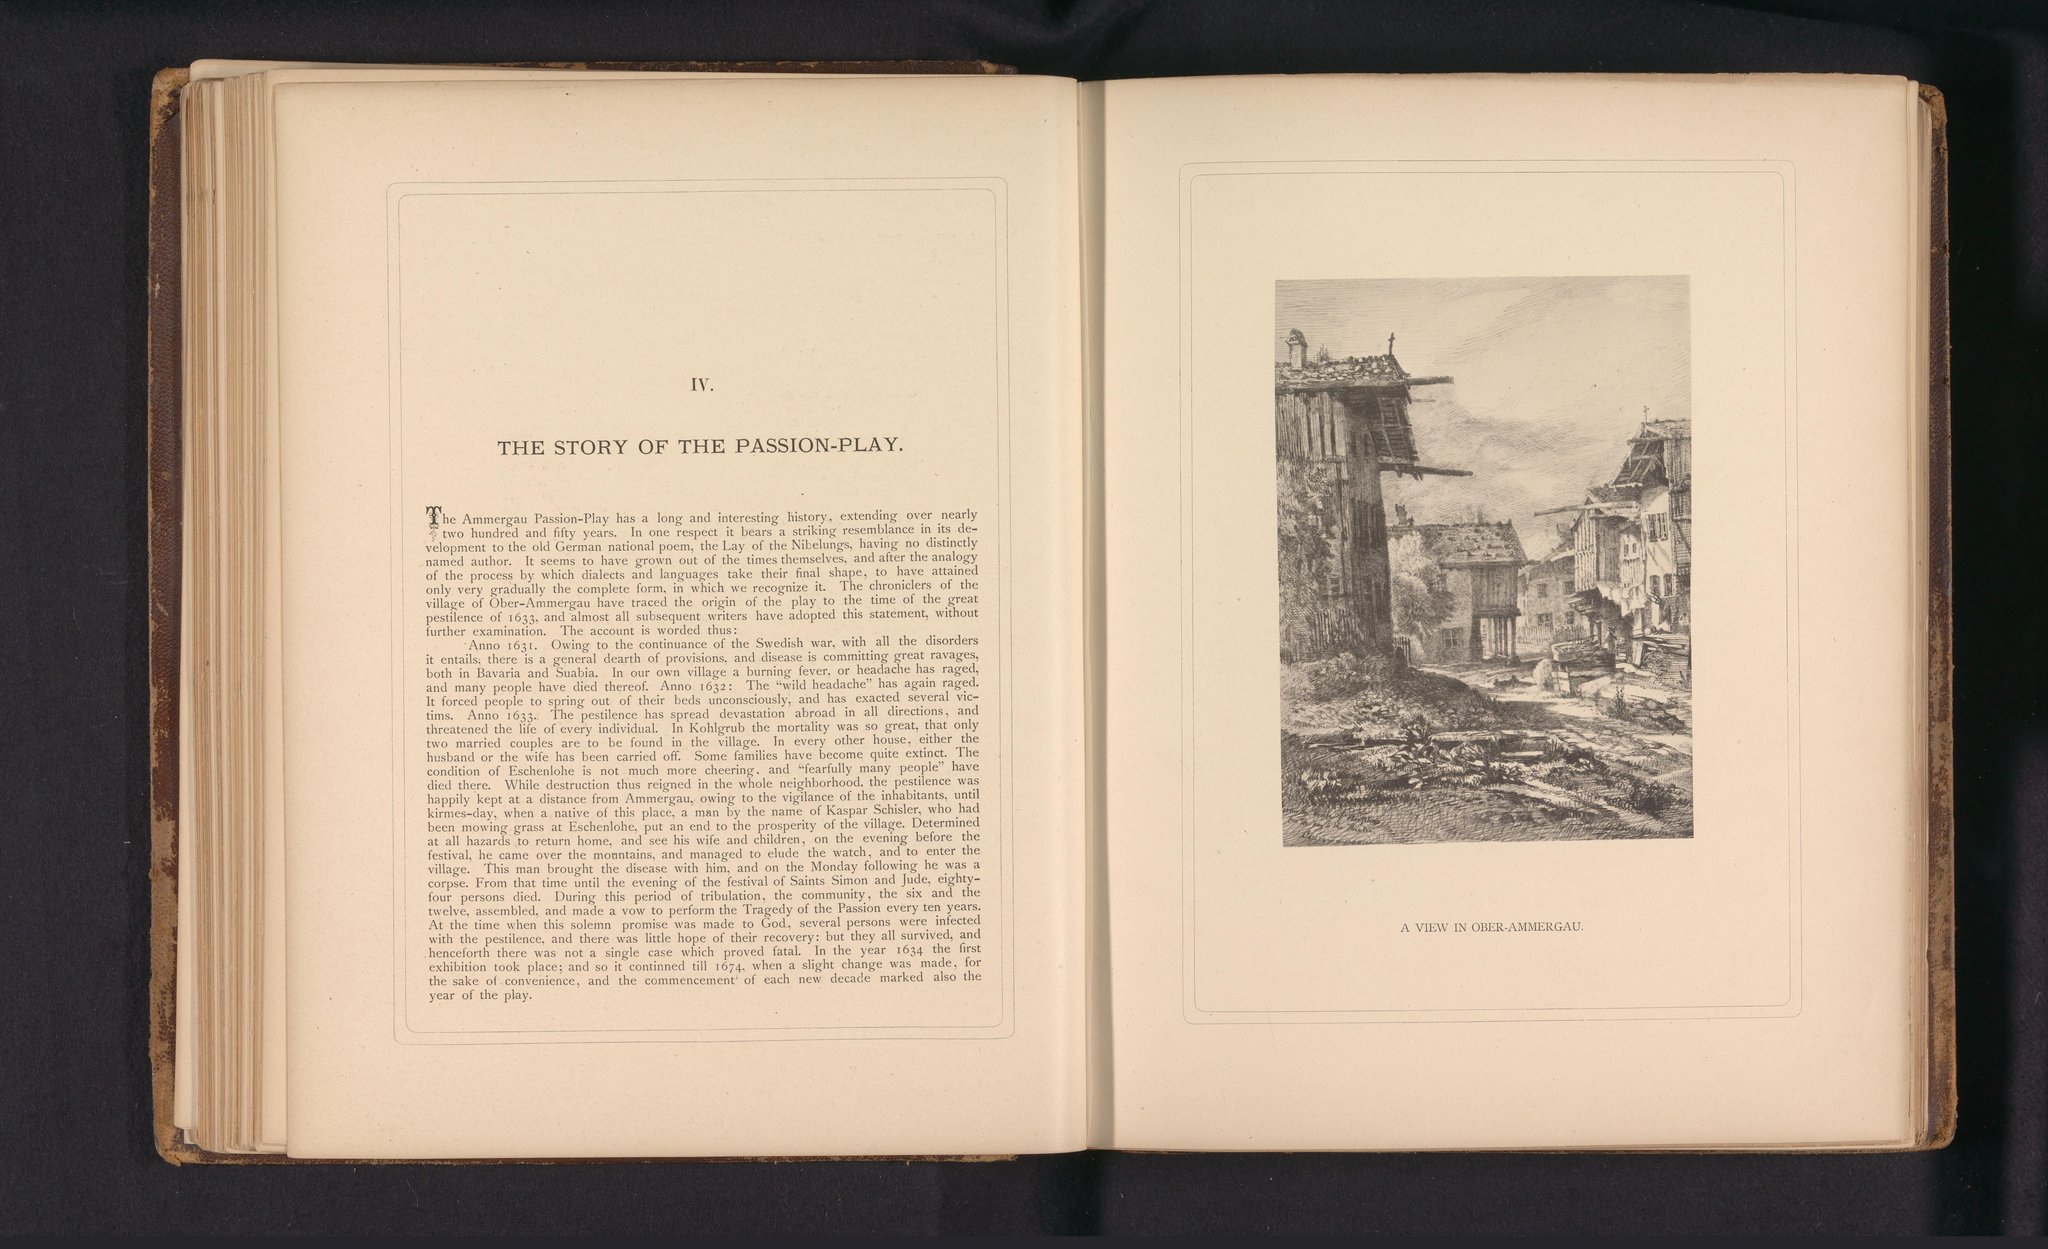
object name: page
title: A view in Ober-Ammergau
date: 1871-1873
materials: paper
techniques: photograph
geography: oberammergau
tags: housing, façade (of house or building), oberammergau